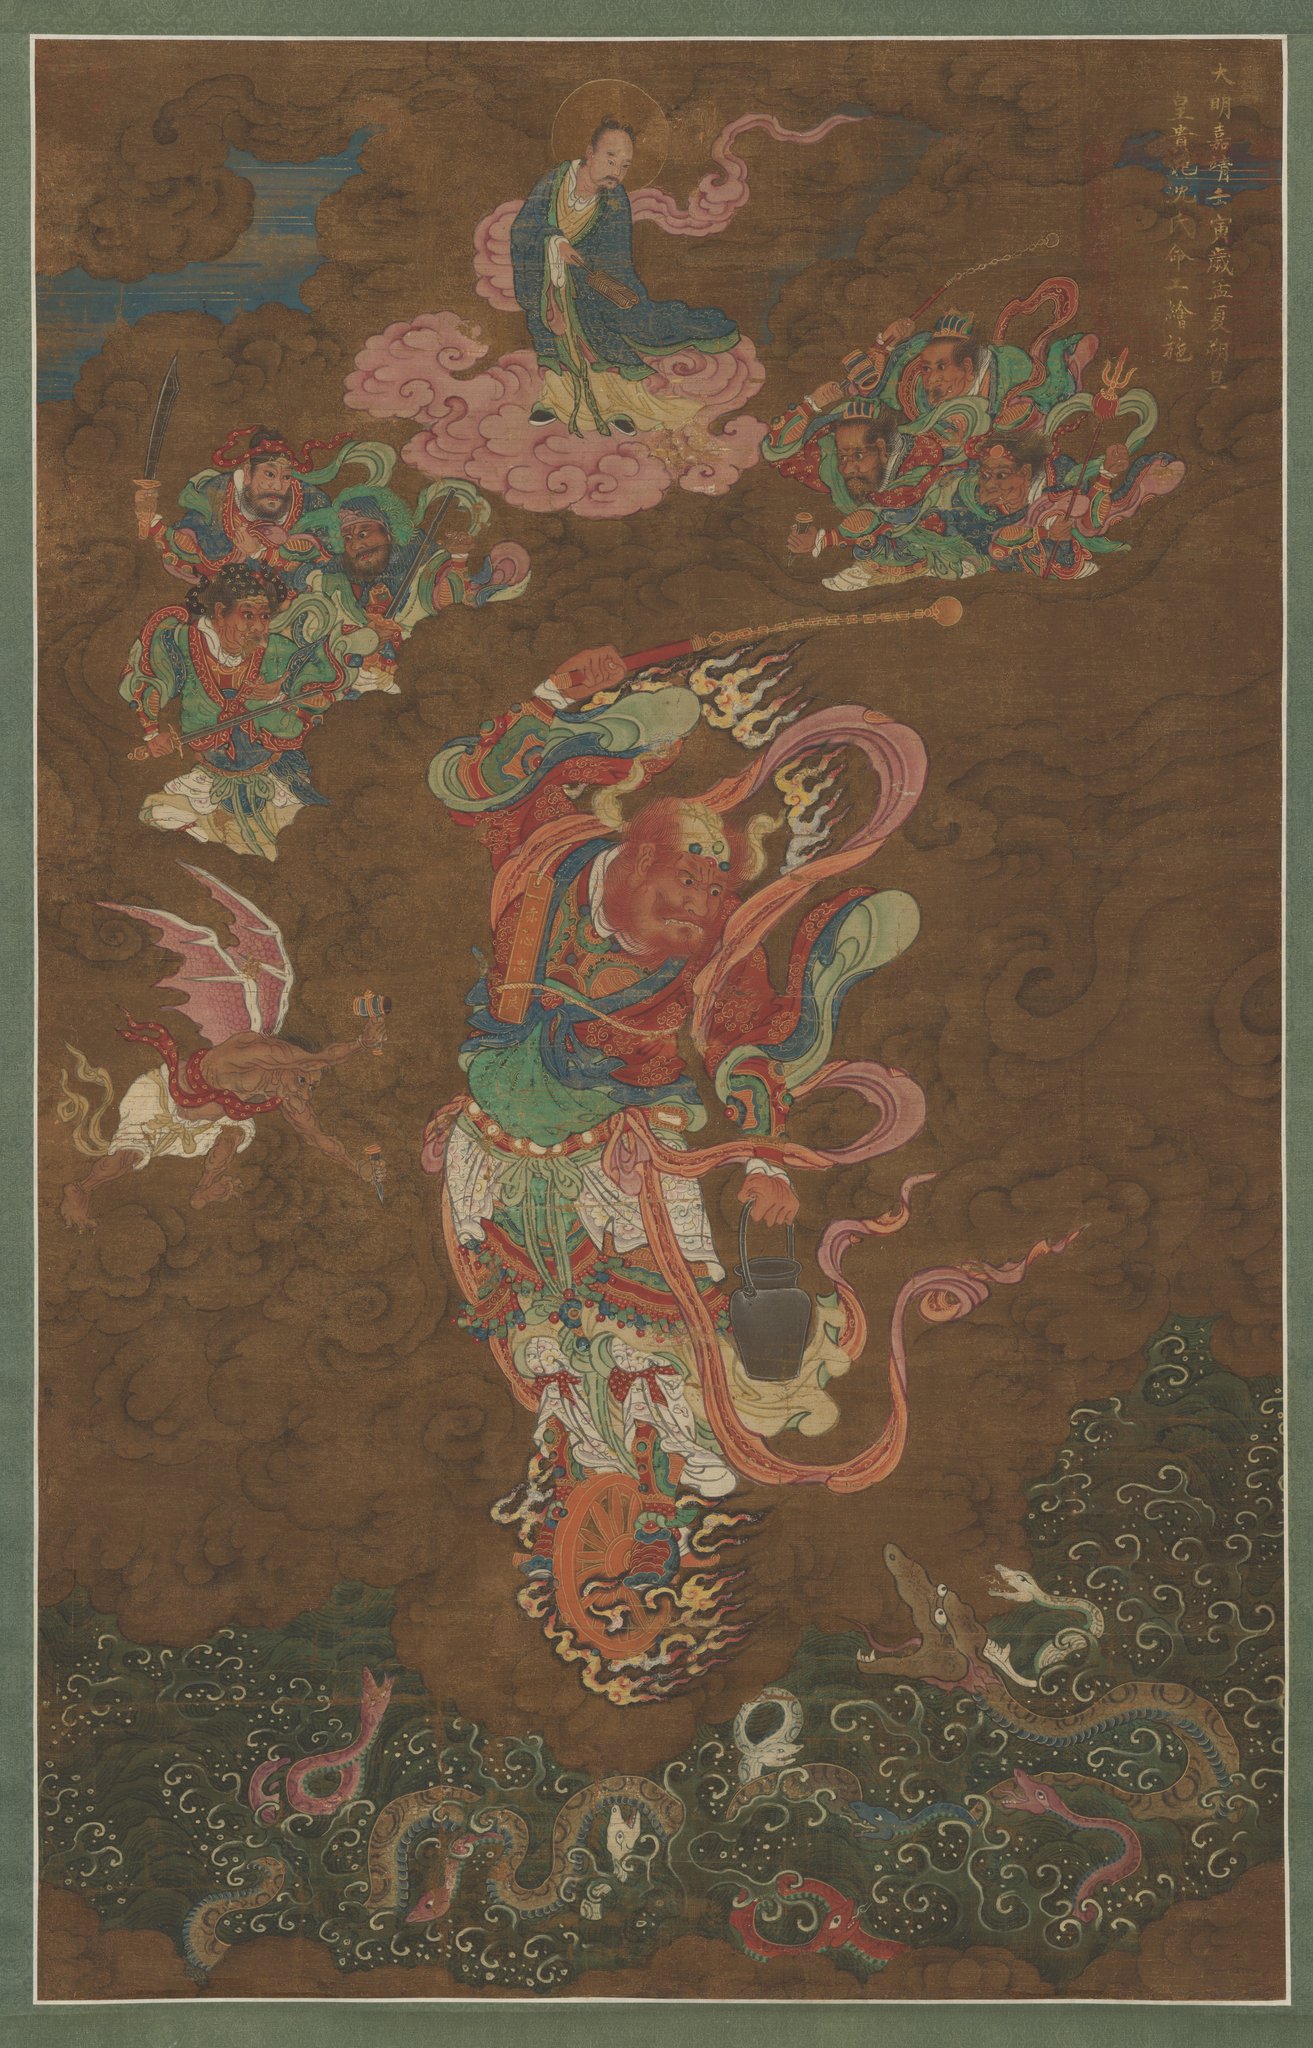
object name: hanging scroll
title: Marshal Wang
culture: chinese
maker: unidentified artist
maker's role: artist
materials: ink, silk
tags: men,mythical creatures,serpents